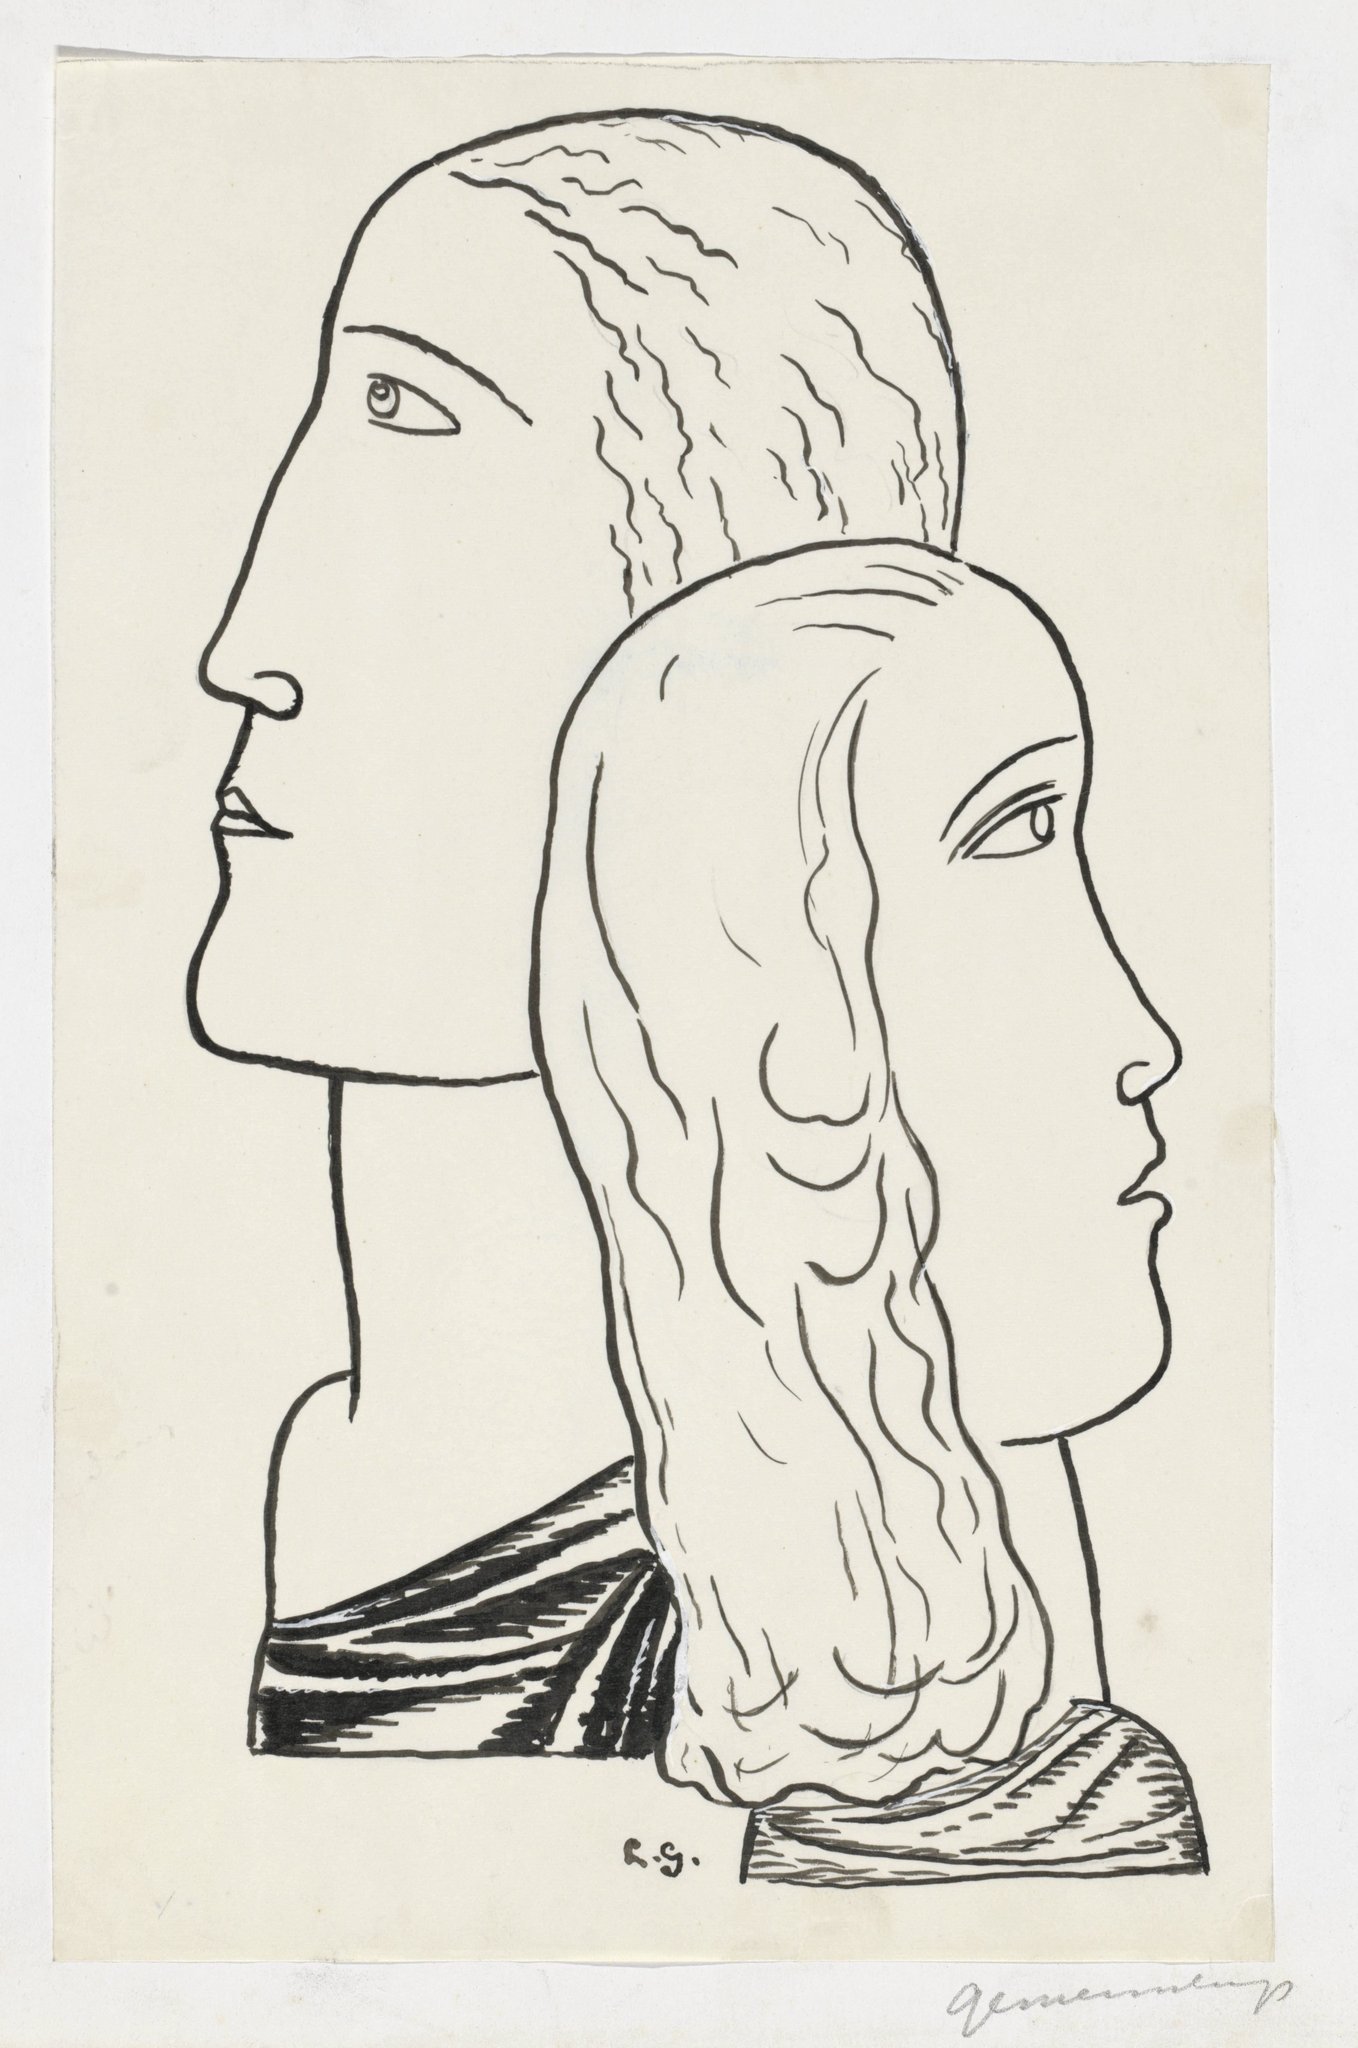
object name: drawing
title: Gezicht van een man en een vrouw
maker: leo gestel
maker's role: draughtsman, print maker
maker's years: 1881-1941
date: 1891-1941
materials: paint, ink, paper, pencil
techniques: brush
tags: female sex; woman, male sex; man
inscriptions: collector's mark: Lugt 2228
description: Ontwerp voor een illustratie voor: De Gemeenschap, uitgegeven tussen 1925-1941.